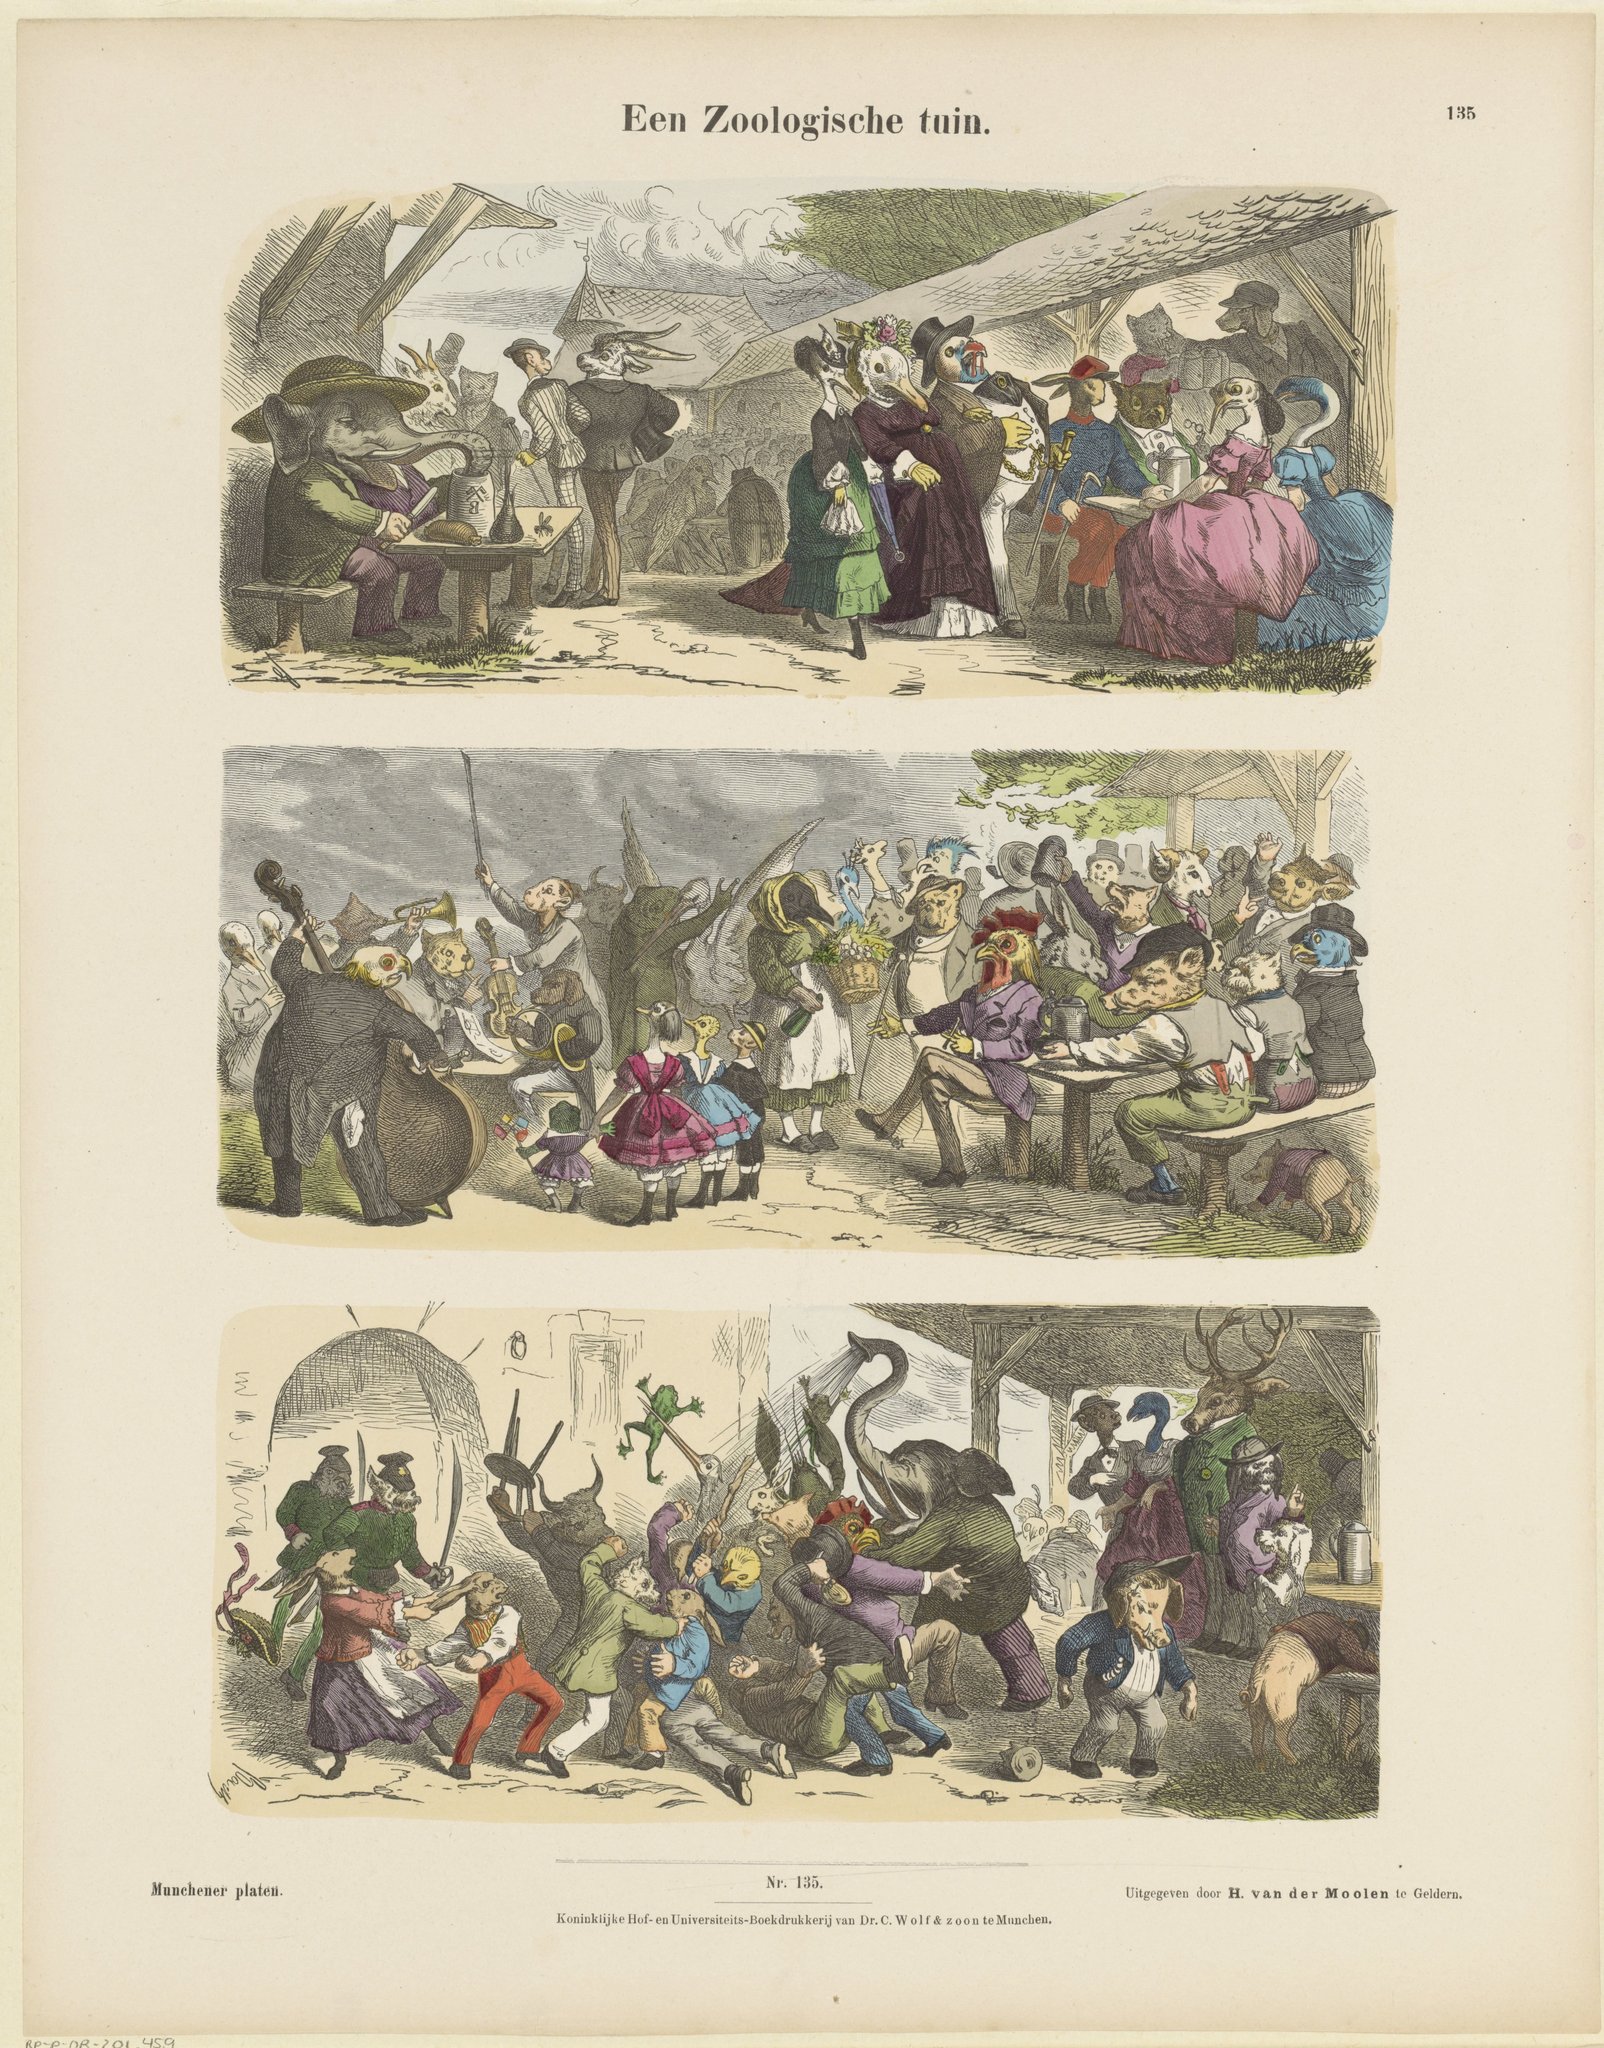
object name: popular print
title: Munchener platen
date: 1843-1920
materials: paper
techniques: colour, letterpress printing, engraving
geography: germany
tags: animals, animals acting as human beings, public festivities, fighting, fist-fight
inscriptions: collector's mark: Lugt 2760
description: Nederlandse editie van een prent uit de reeks "Munchener platen" uitgegeven door K. Braun & Fr. Schneider te München met het adres van wederverkoper Hermann van der Moolen.